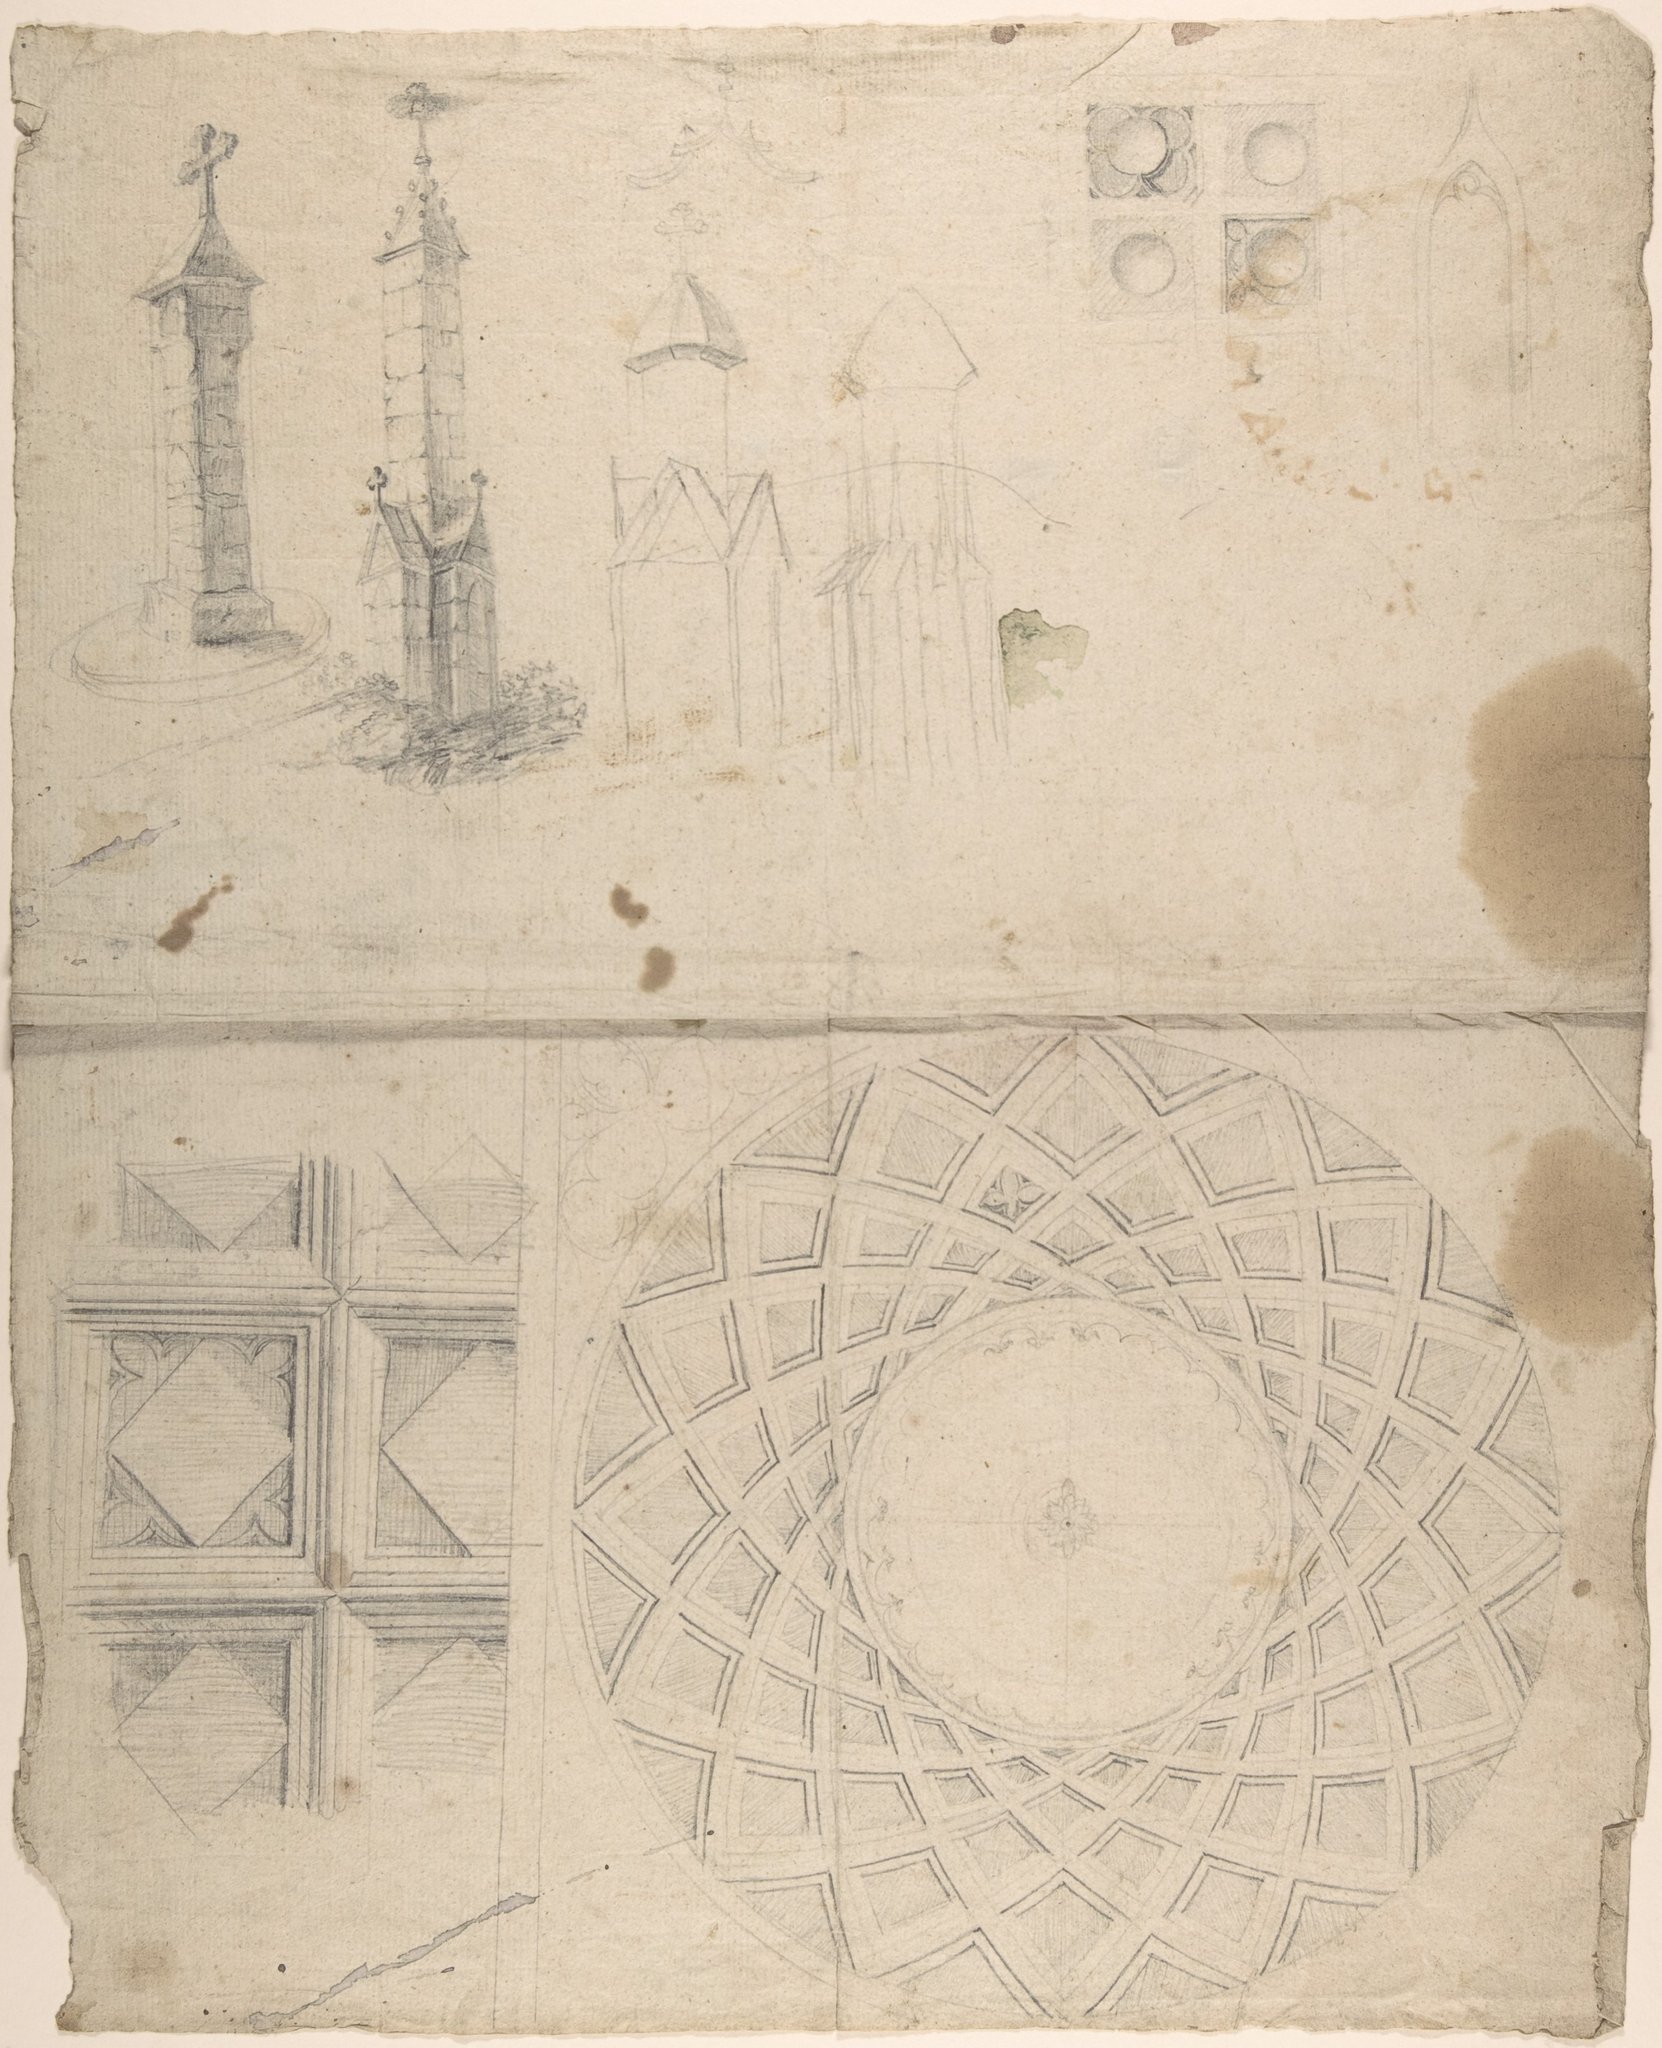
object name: drawing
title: Design for coffered cupola interior and monuments (recto); details of wall decoration (verso)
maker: anonymous, german, 19th century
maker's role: artist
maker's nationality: german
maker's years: 1800-1899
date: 1801-1833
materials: graphite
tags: architecture